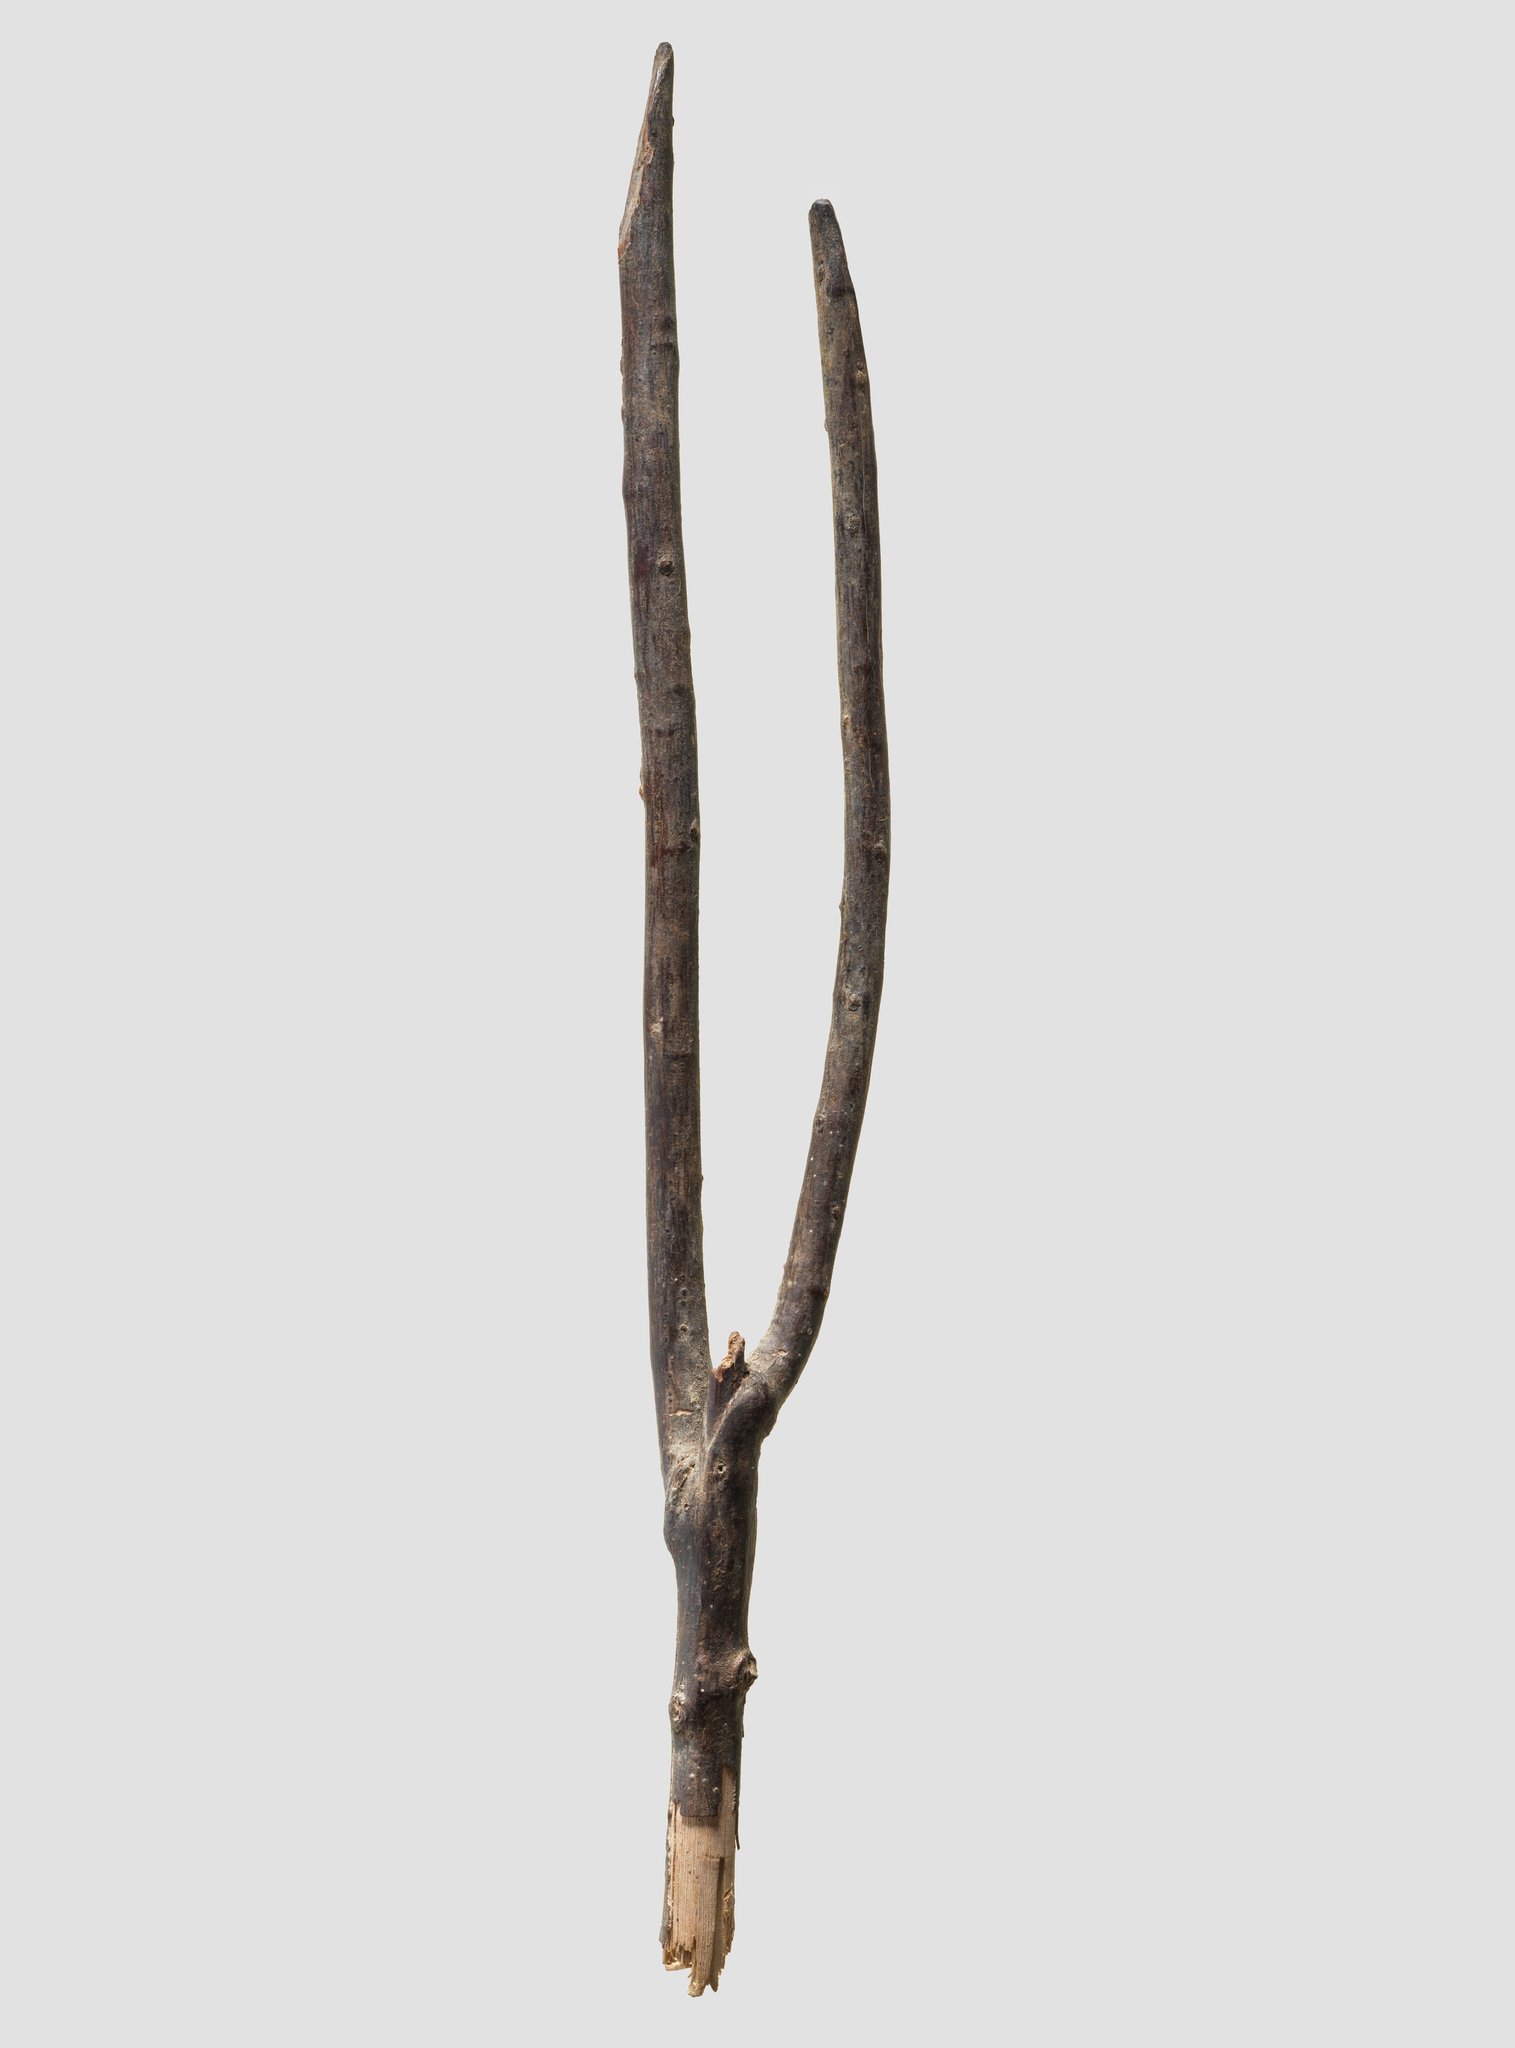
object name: weaving tool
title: Forked twig weaving tool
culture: alanic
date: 601-900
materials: wood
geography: caucasus